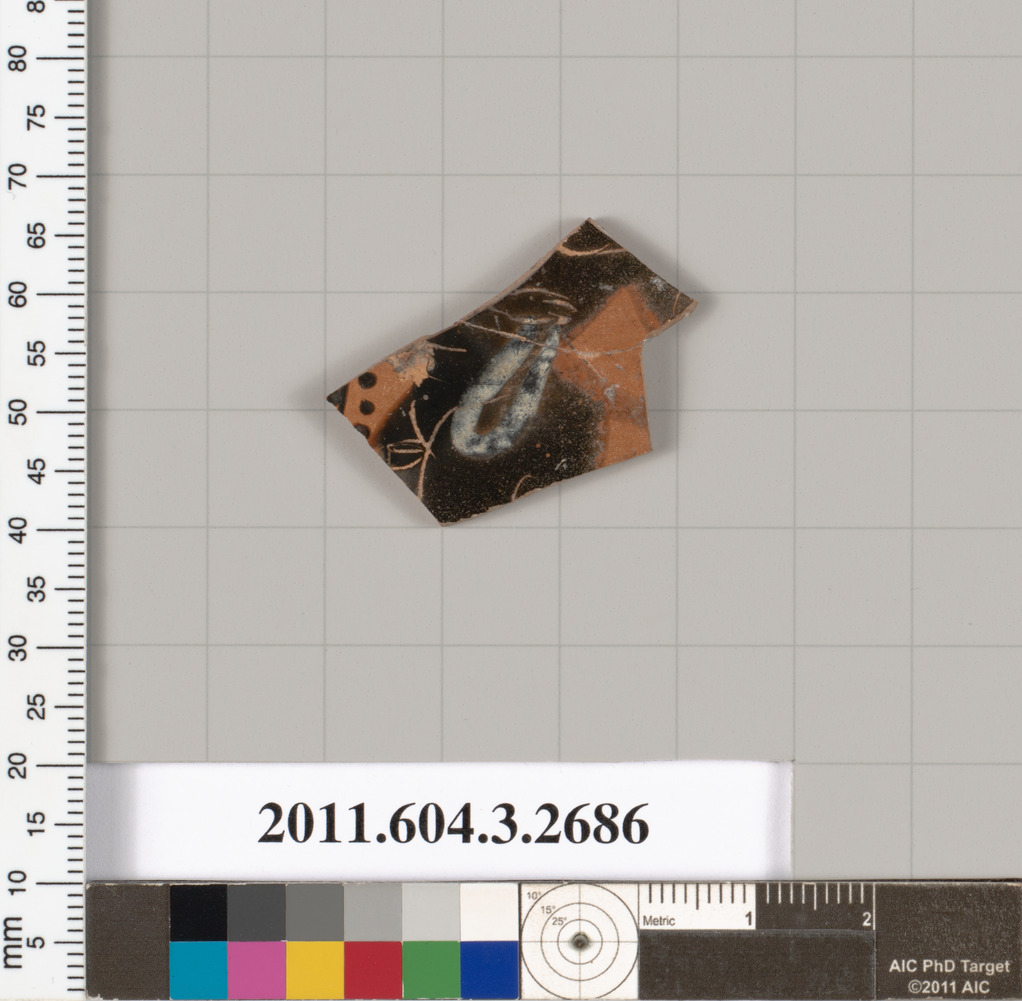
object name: oinochoe fragment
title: Terracotta fragment of an oinochoe (jug)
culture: greek, attic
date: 510-500 BCE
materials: terracotta